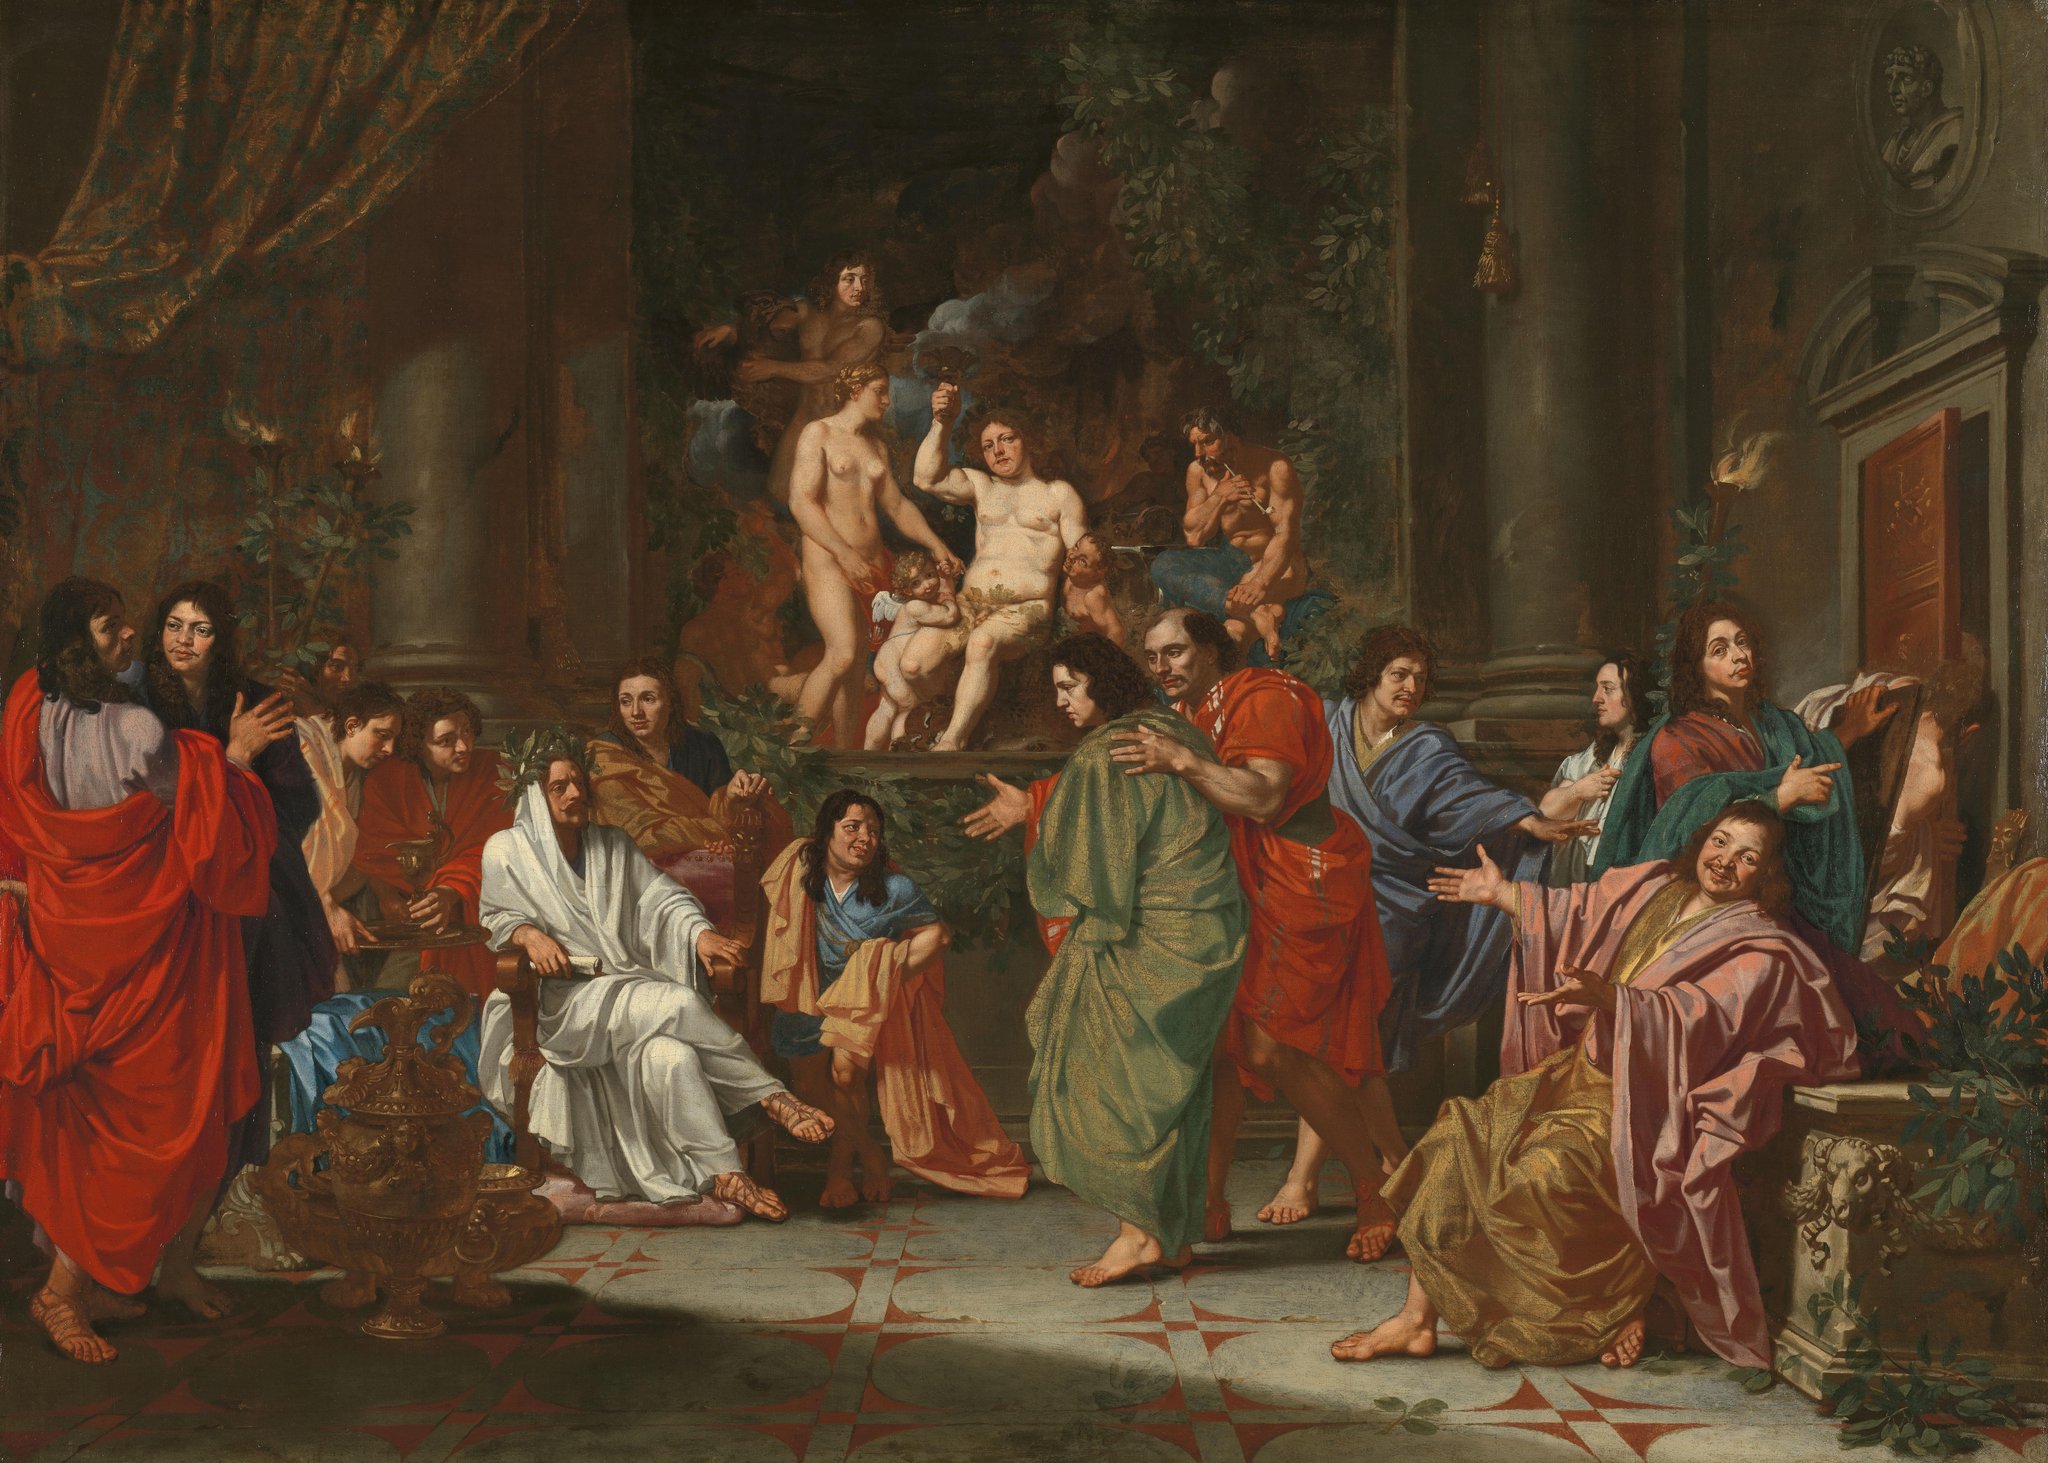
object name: painting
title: The Induction of a New Member into the Band of Northern Painters in Rome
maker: Anonymous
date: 1660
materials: canvas, oil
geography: low countries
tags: initiation (~ membership of a society), circle, club of artists, initiation in the arts, bohemian life of artist, rome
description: De inwijding van een nieuw lid van de Bentveughels te Rome. Interieur met een groep kunstenaars gekleed in lange mantels, in het midden wordt een man voorgesteld aan een zittende man met een lauwerkrans op het hoofd. Op de achtergrond een schilderij van Bacchus.